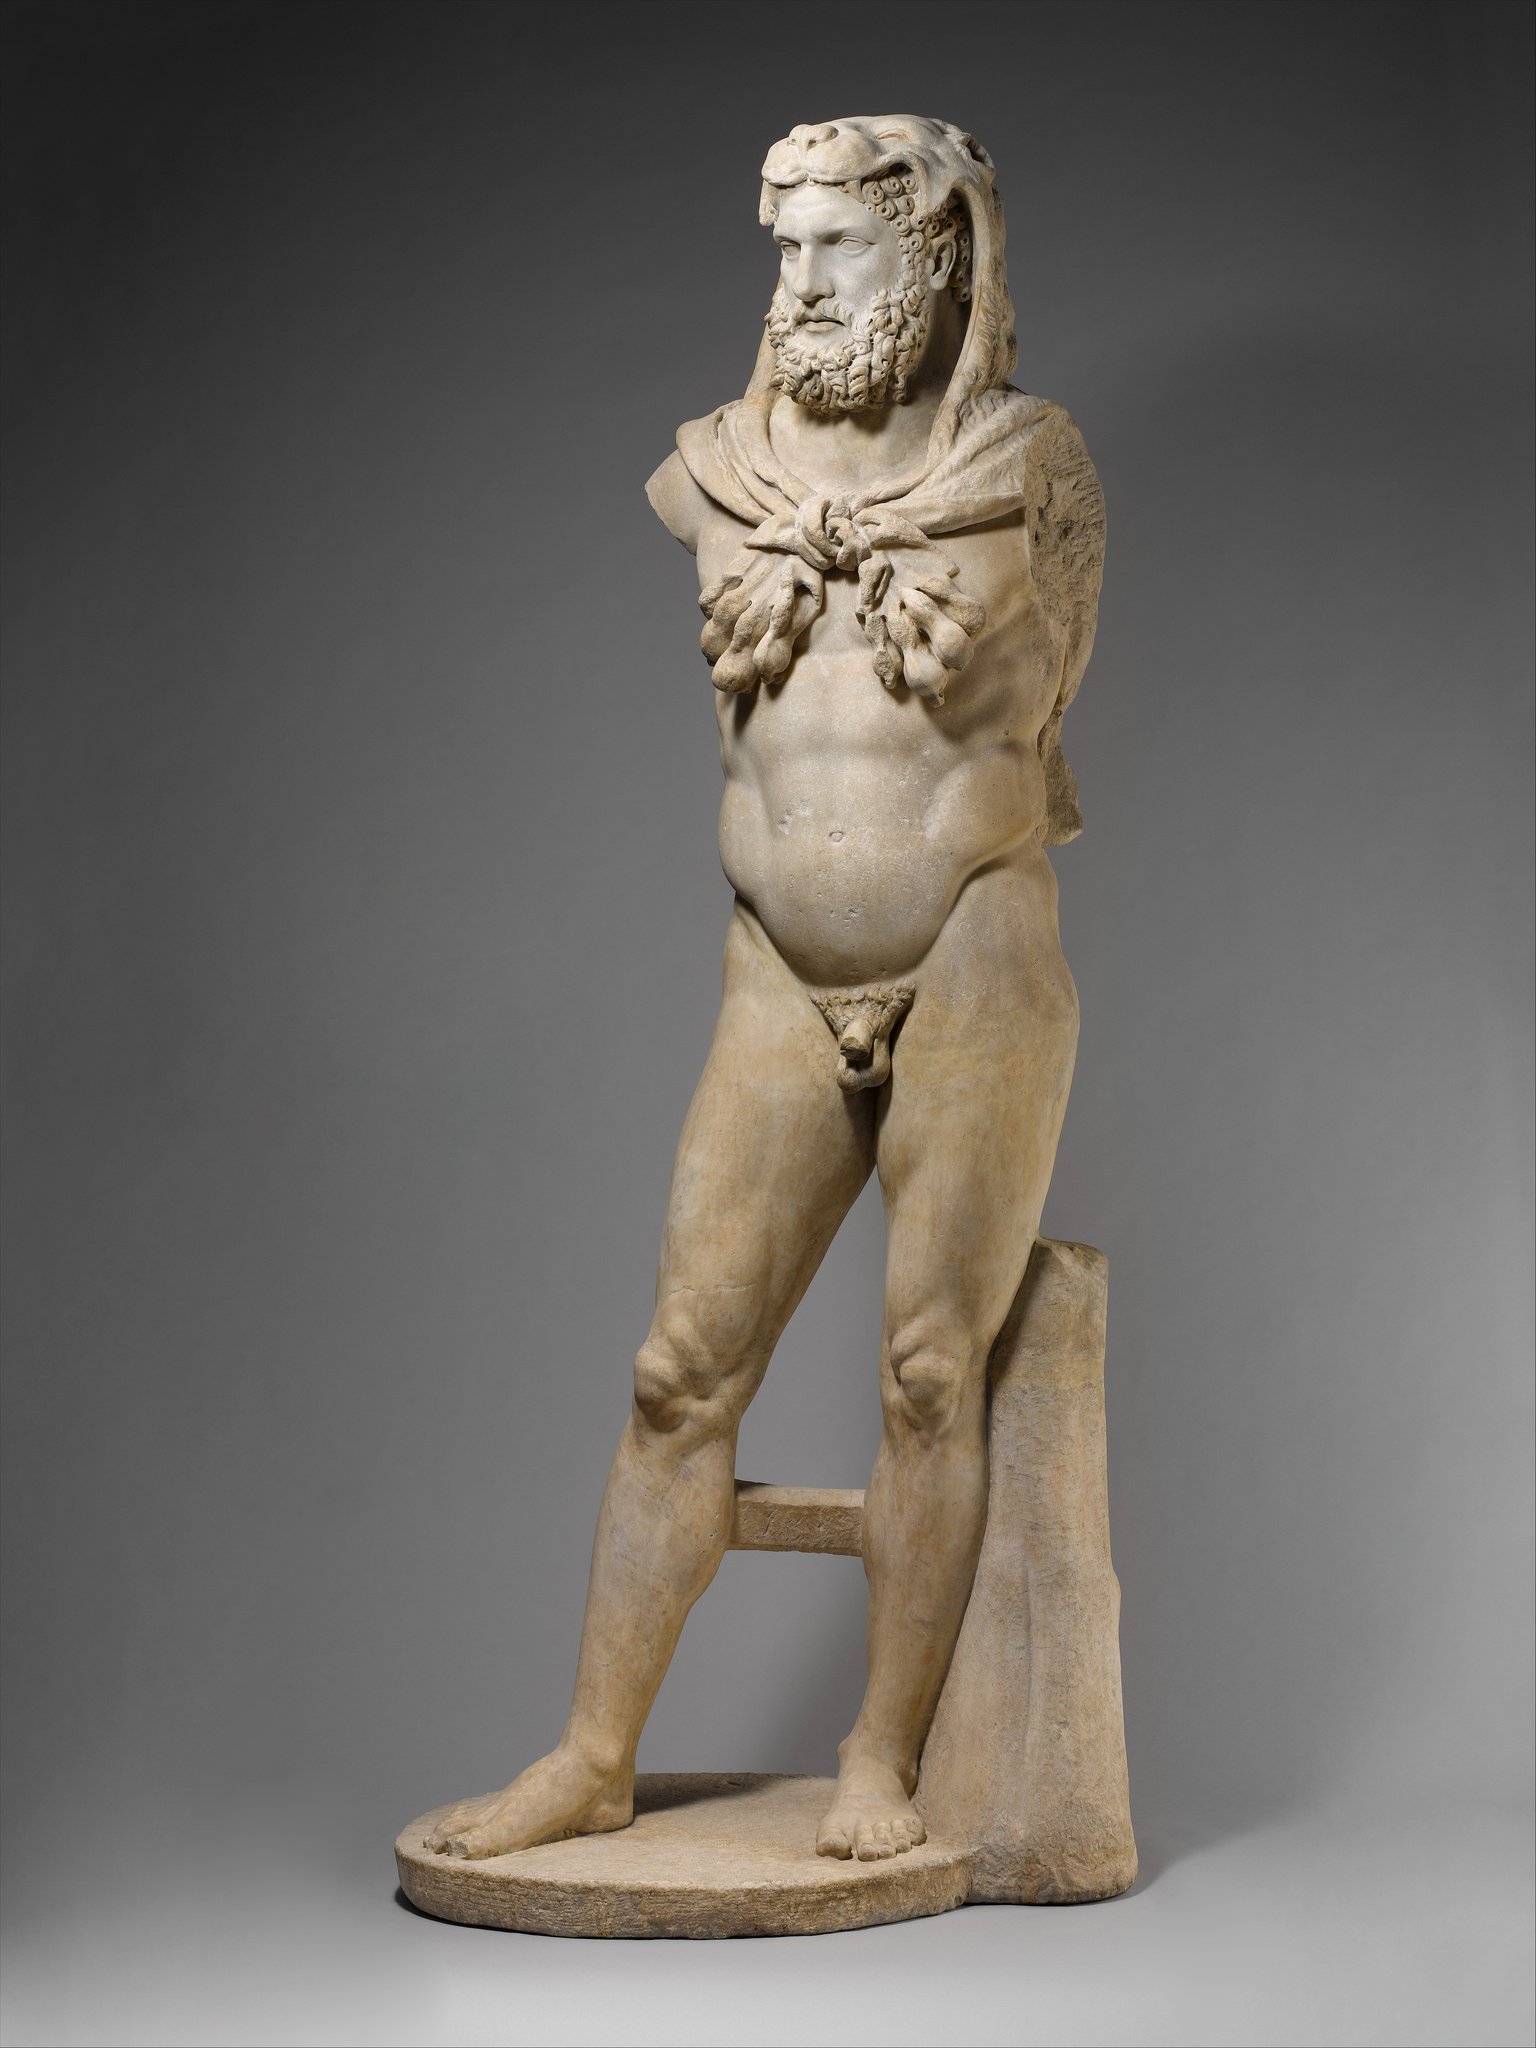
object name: statue of herakles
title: Marble statue of a bearded Hercules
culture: roman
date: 68-98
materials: marble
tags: male nudes,hercules,lions